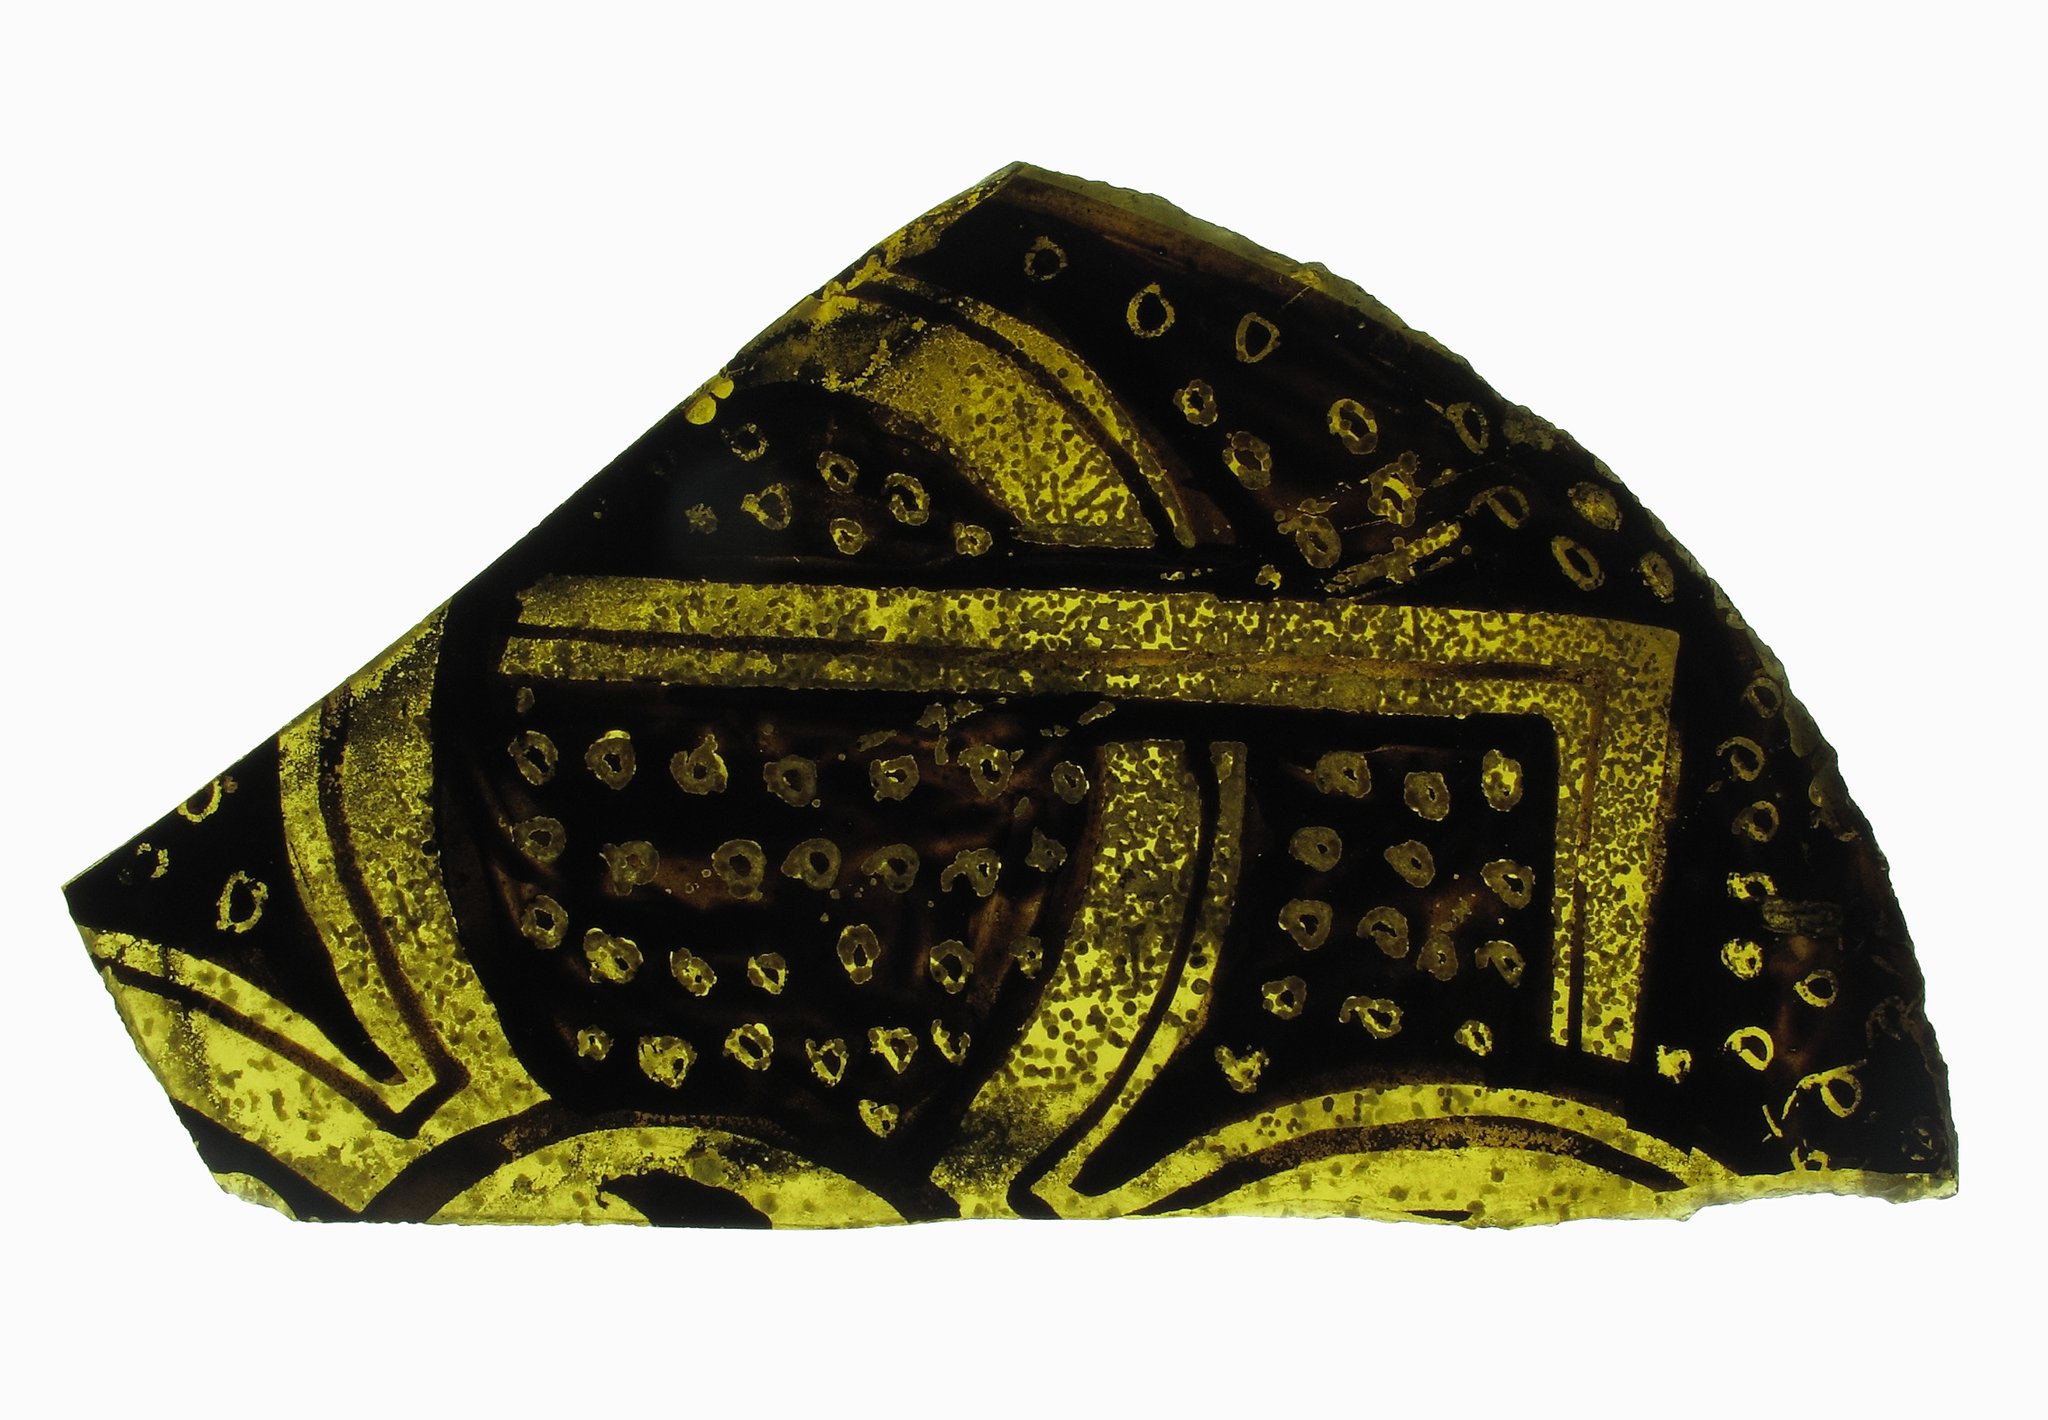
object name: fragment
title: Glass Fragment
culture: european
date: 1301-1400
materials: glass, metal